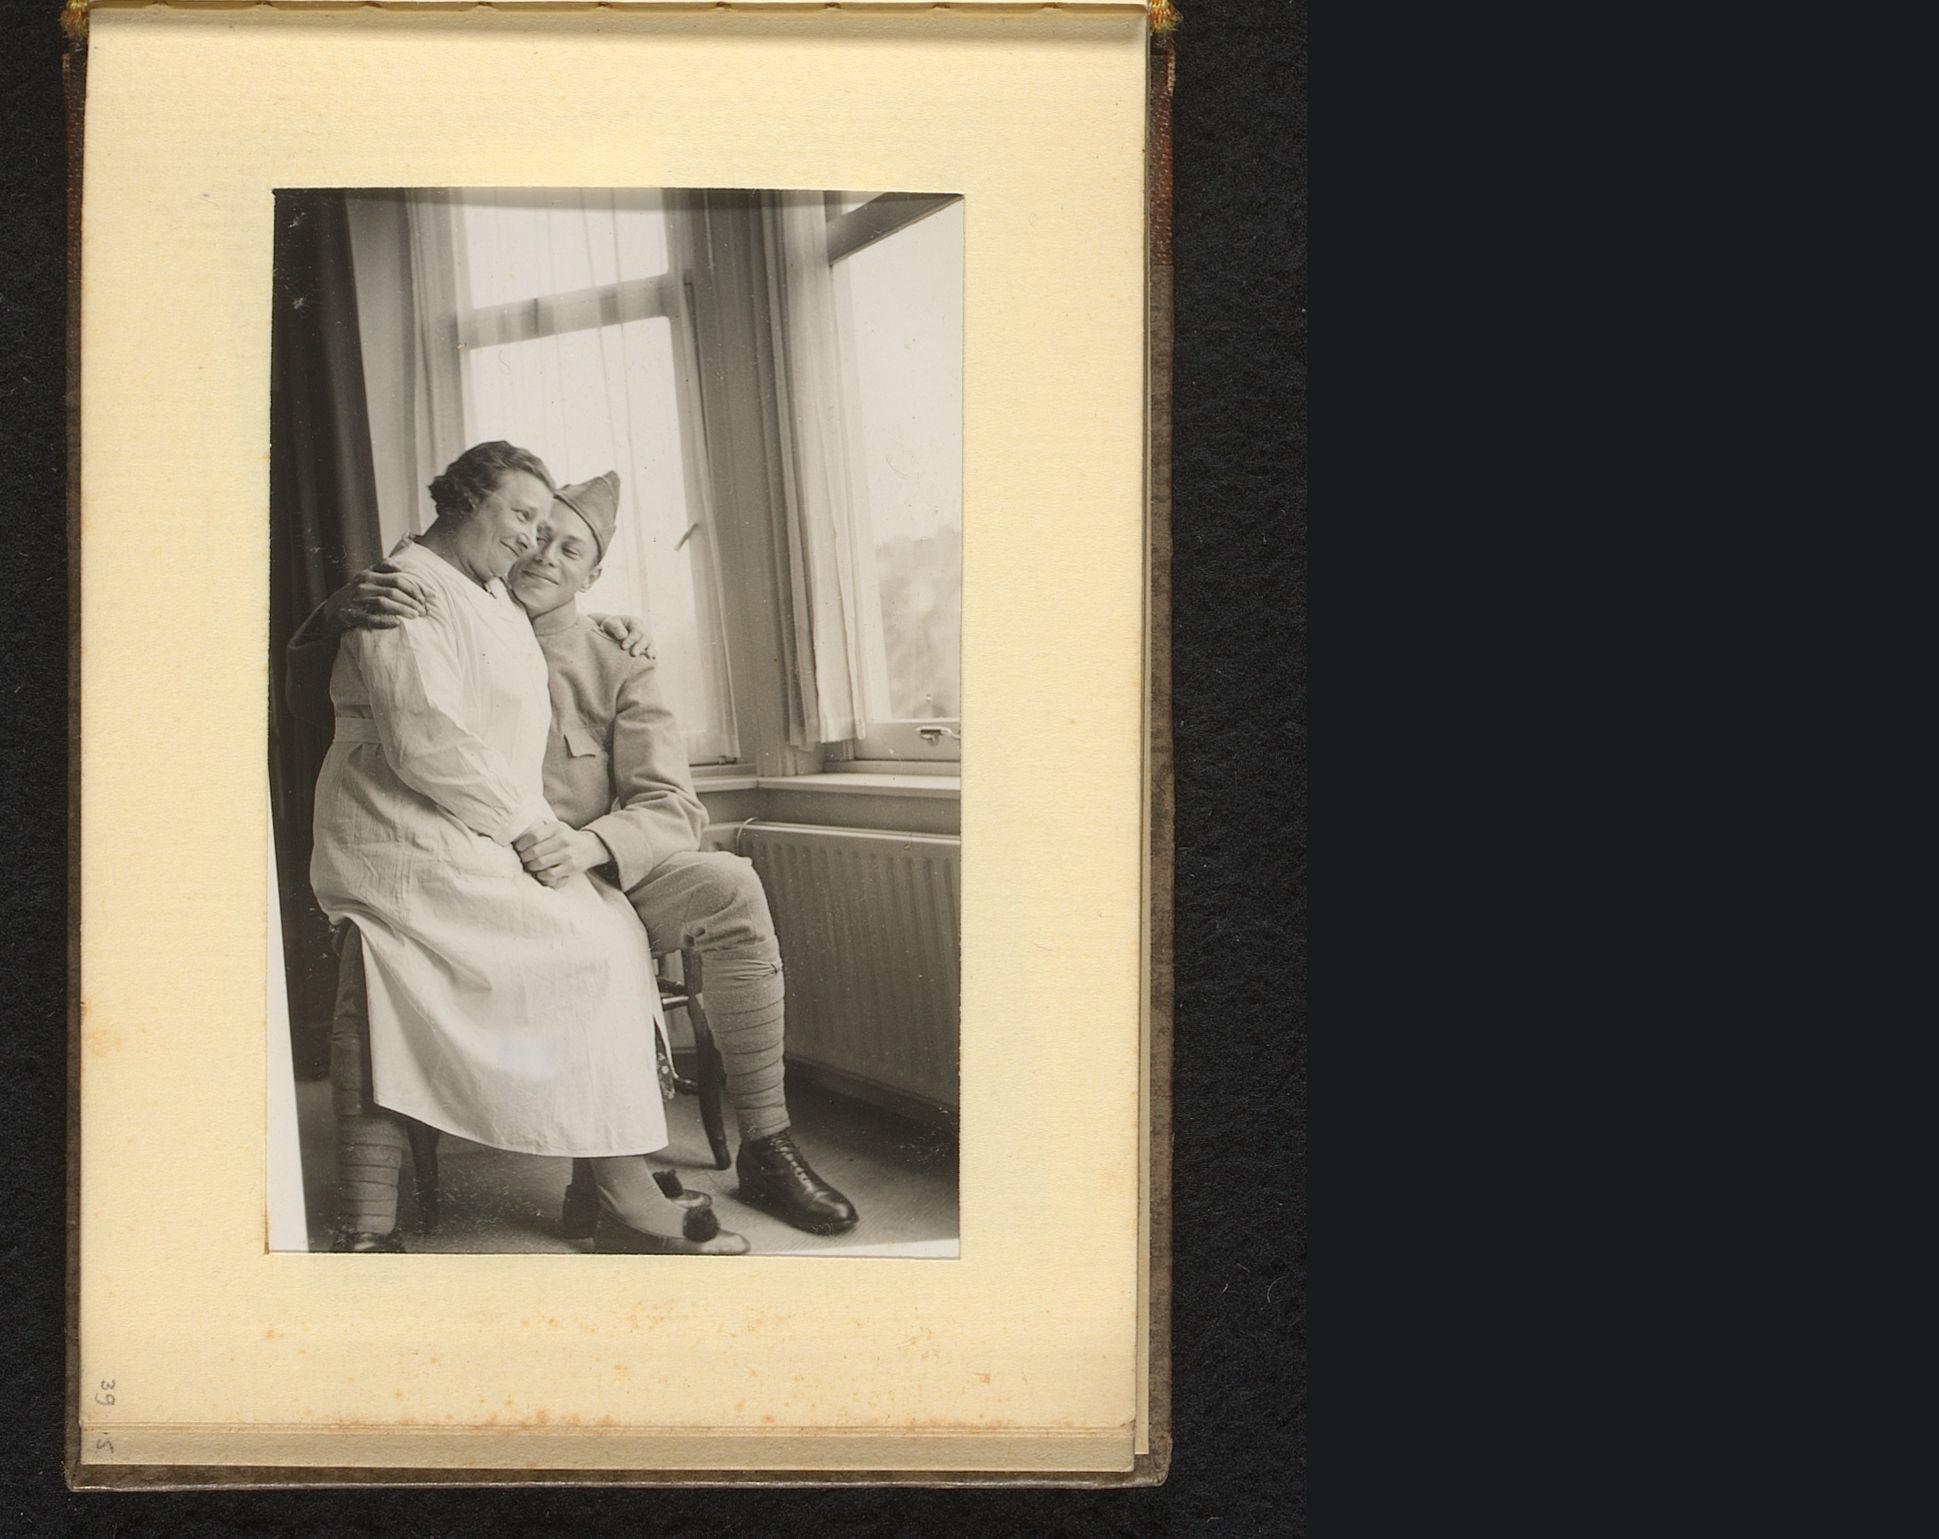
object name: album leaf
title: Vrouw op schoot bij een man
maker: norbert van den berg (1901-1972)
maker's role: amateurfotograaf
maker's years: 1901-1972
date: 1935-1950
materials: paper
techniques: gelatin silver print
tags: adult woman, adult man, sitting in someone's lap